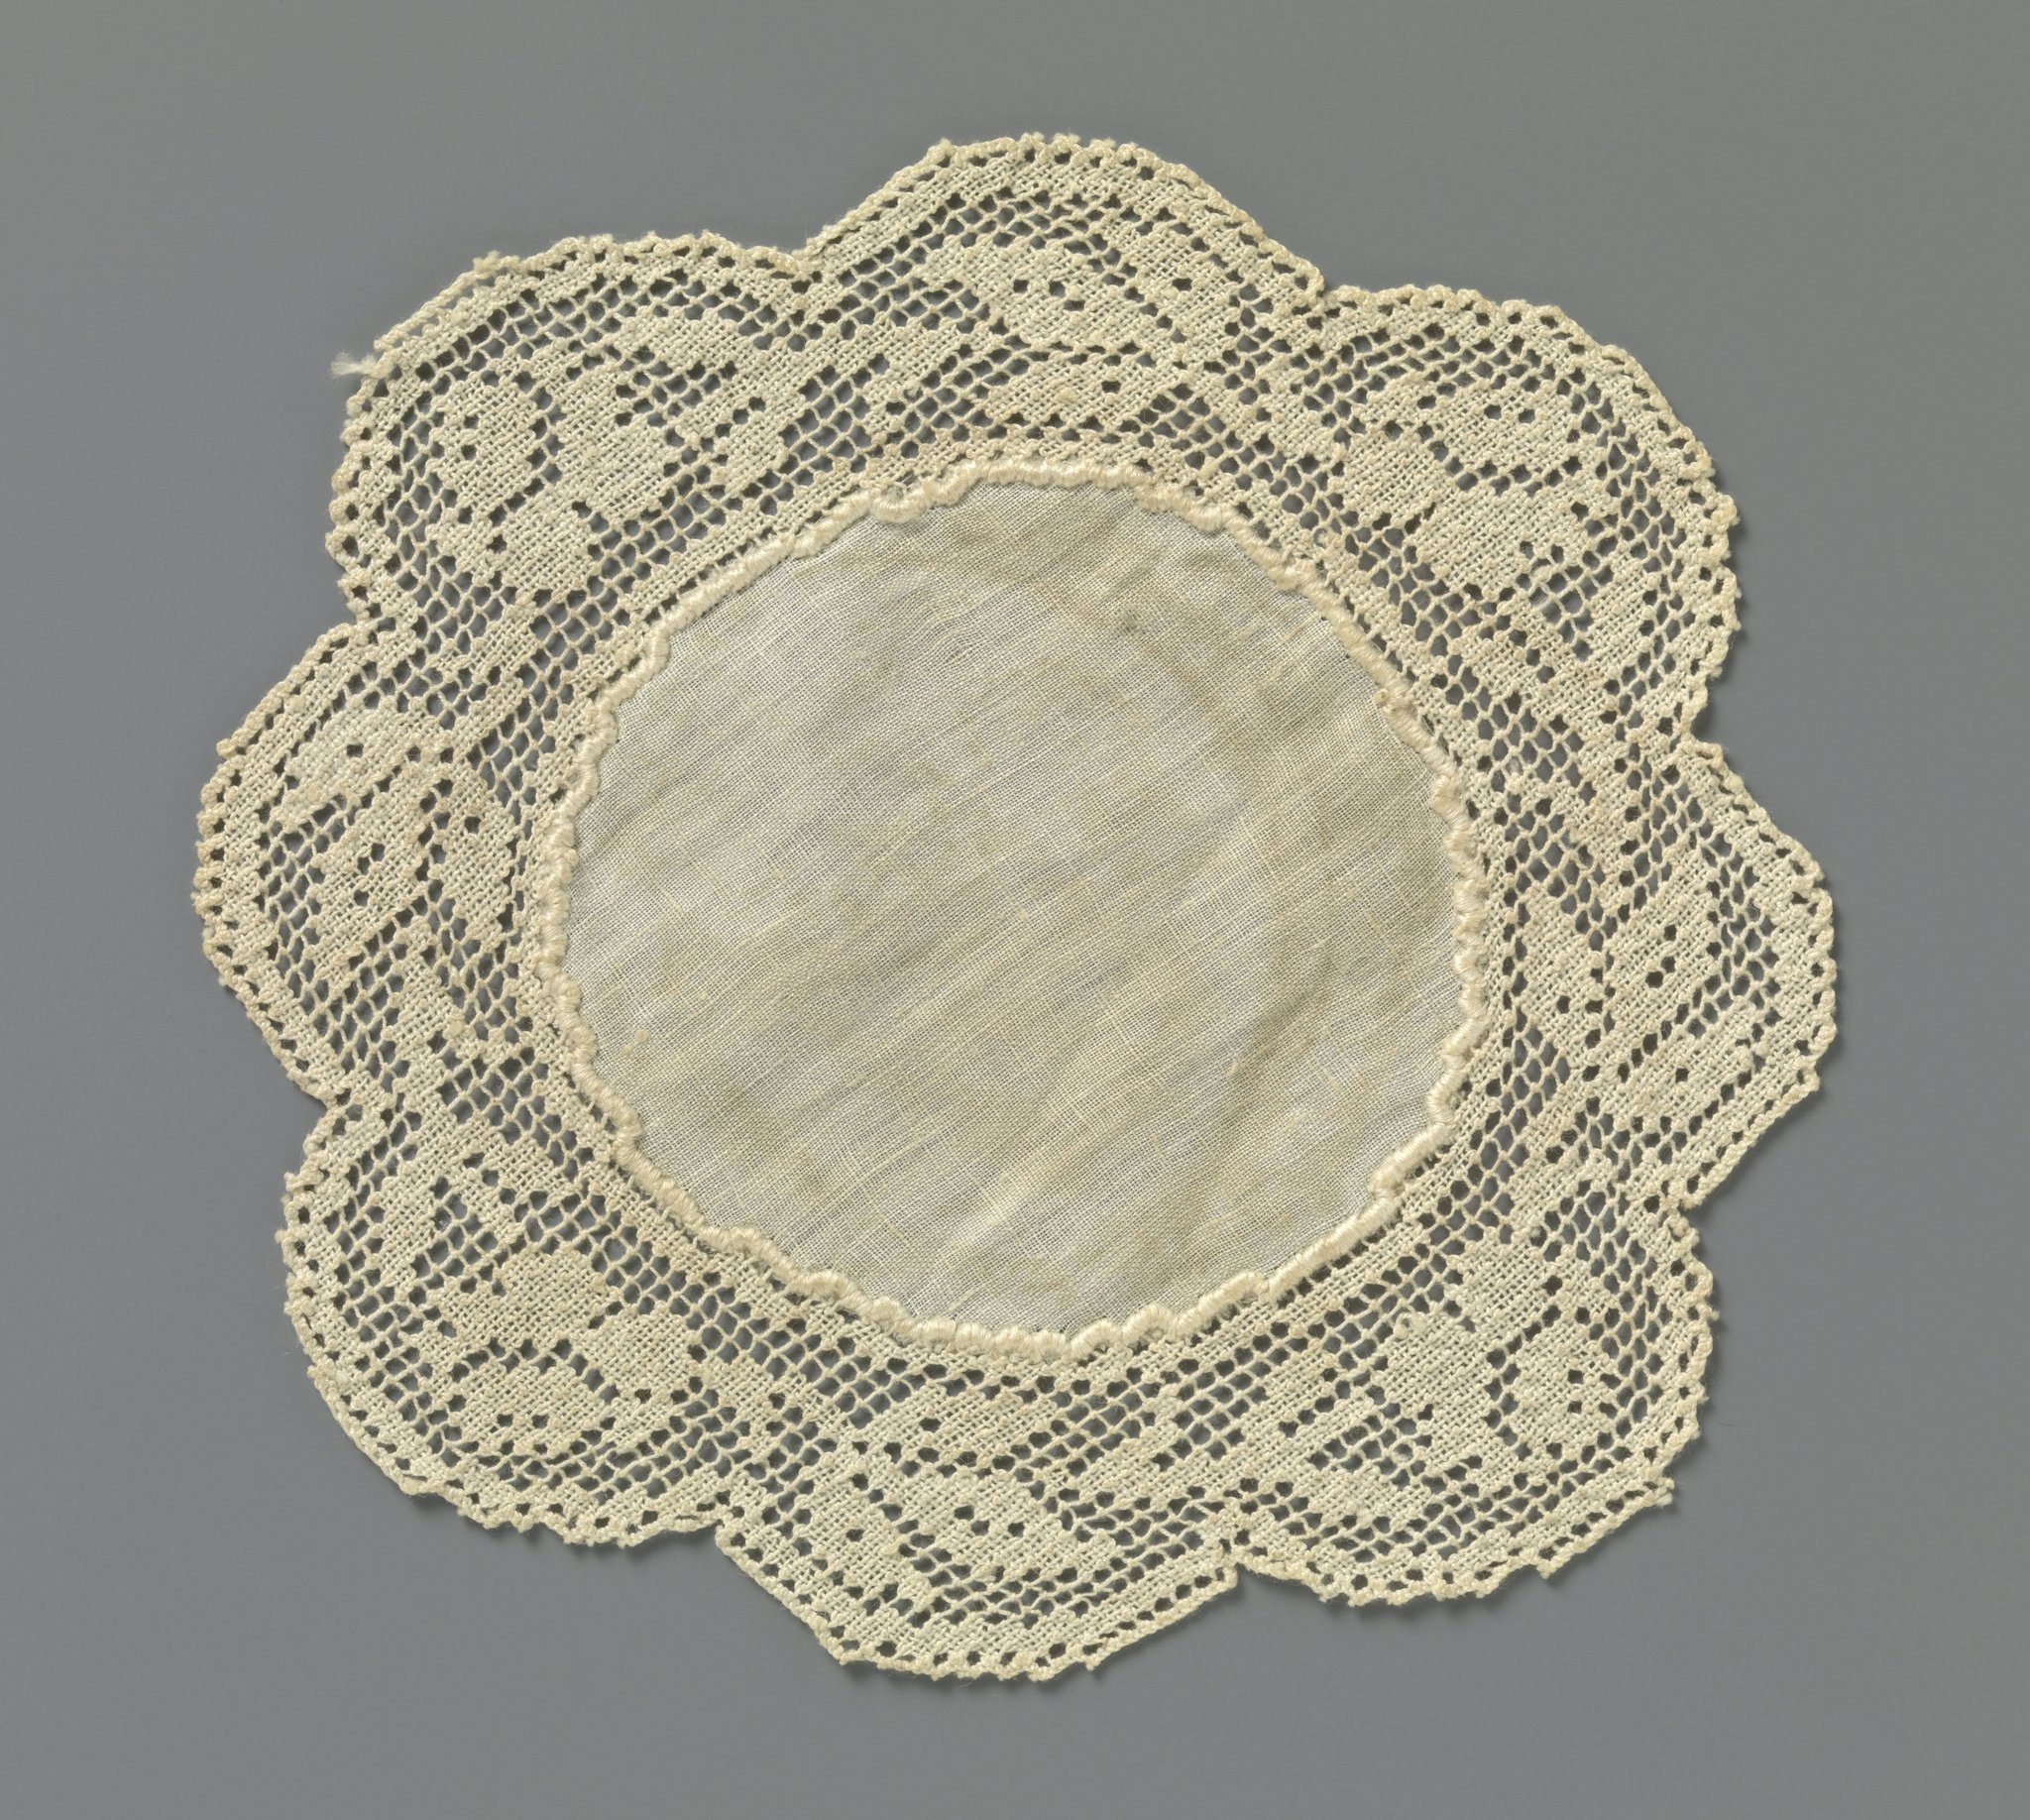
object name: mat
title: Rond kleedje van batist met filetrand versierd met rozentakjes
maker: Anonymous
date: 1900-1949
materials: cotton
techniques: stopwork, filet lace, filet knotwork, lace embroidery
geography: netherlands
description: Kleedje van naturelkleurige batist met een naturelkleurige rand van kantborduurwerk: filetkant. Rond model. Patroon met een aaneenschakeling van een rozentakje afgewisseld met een driedelig blad. De motieven zijn geborduurd met de doorstoptechniek op filetknoopwerk: een geknoopt netwerk met vierkante mazen. Geschulpte rand waarbij één schulp steeds één bloem of één blad omvat.